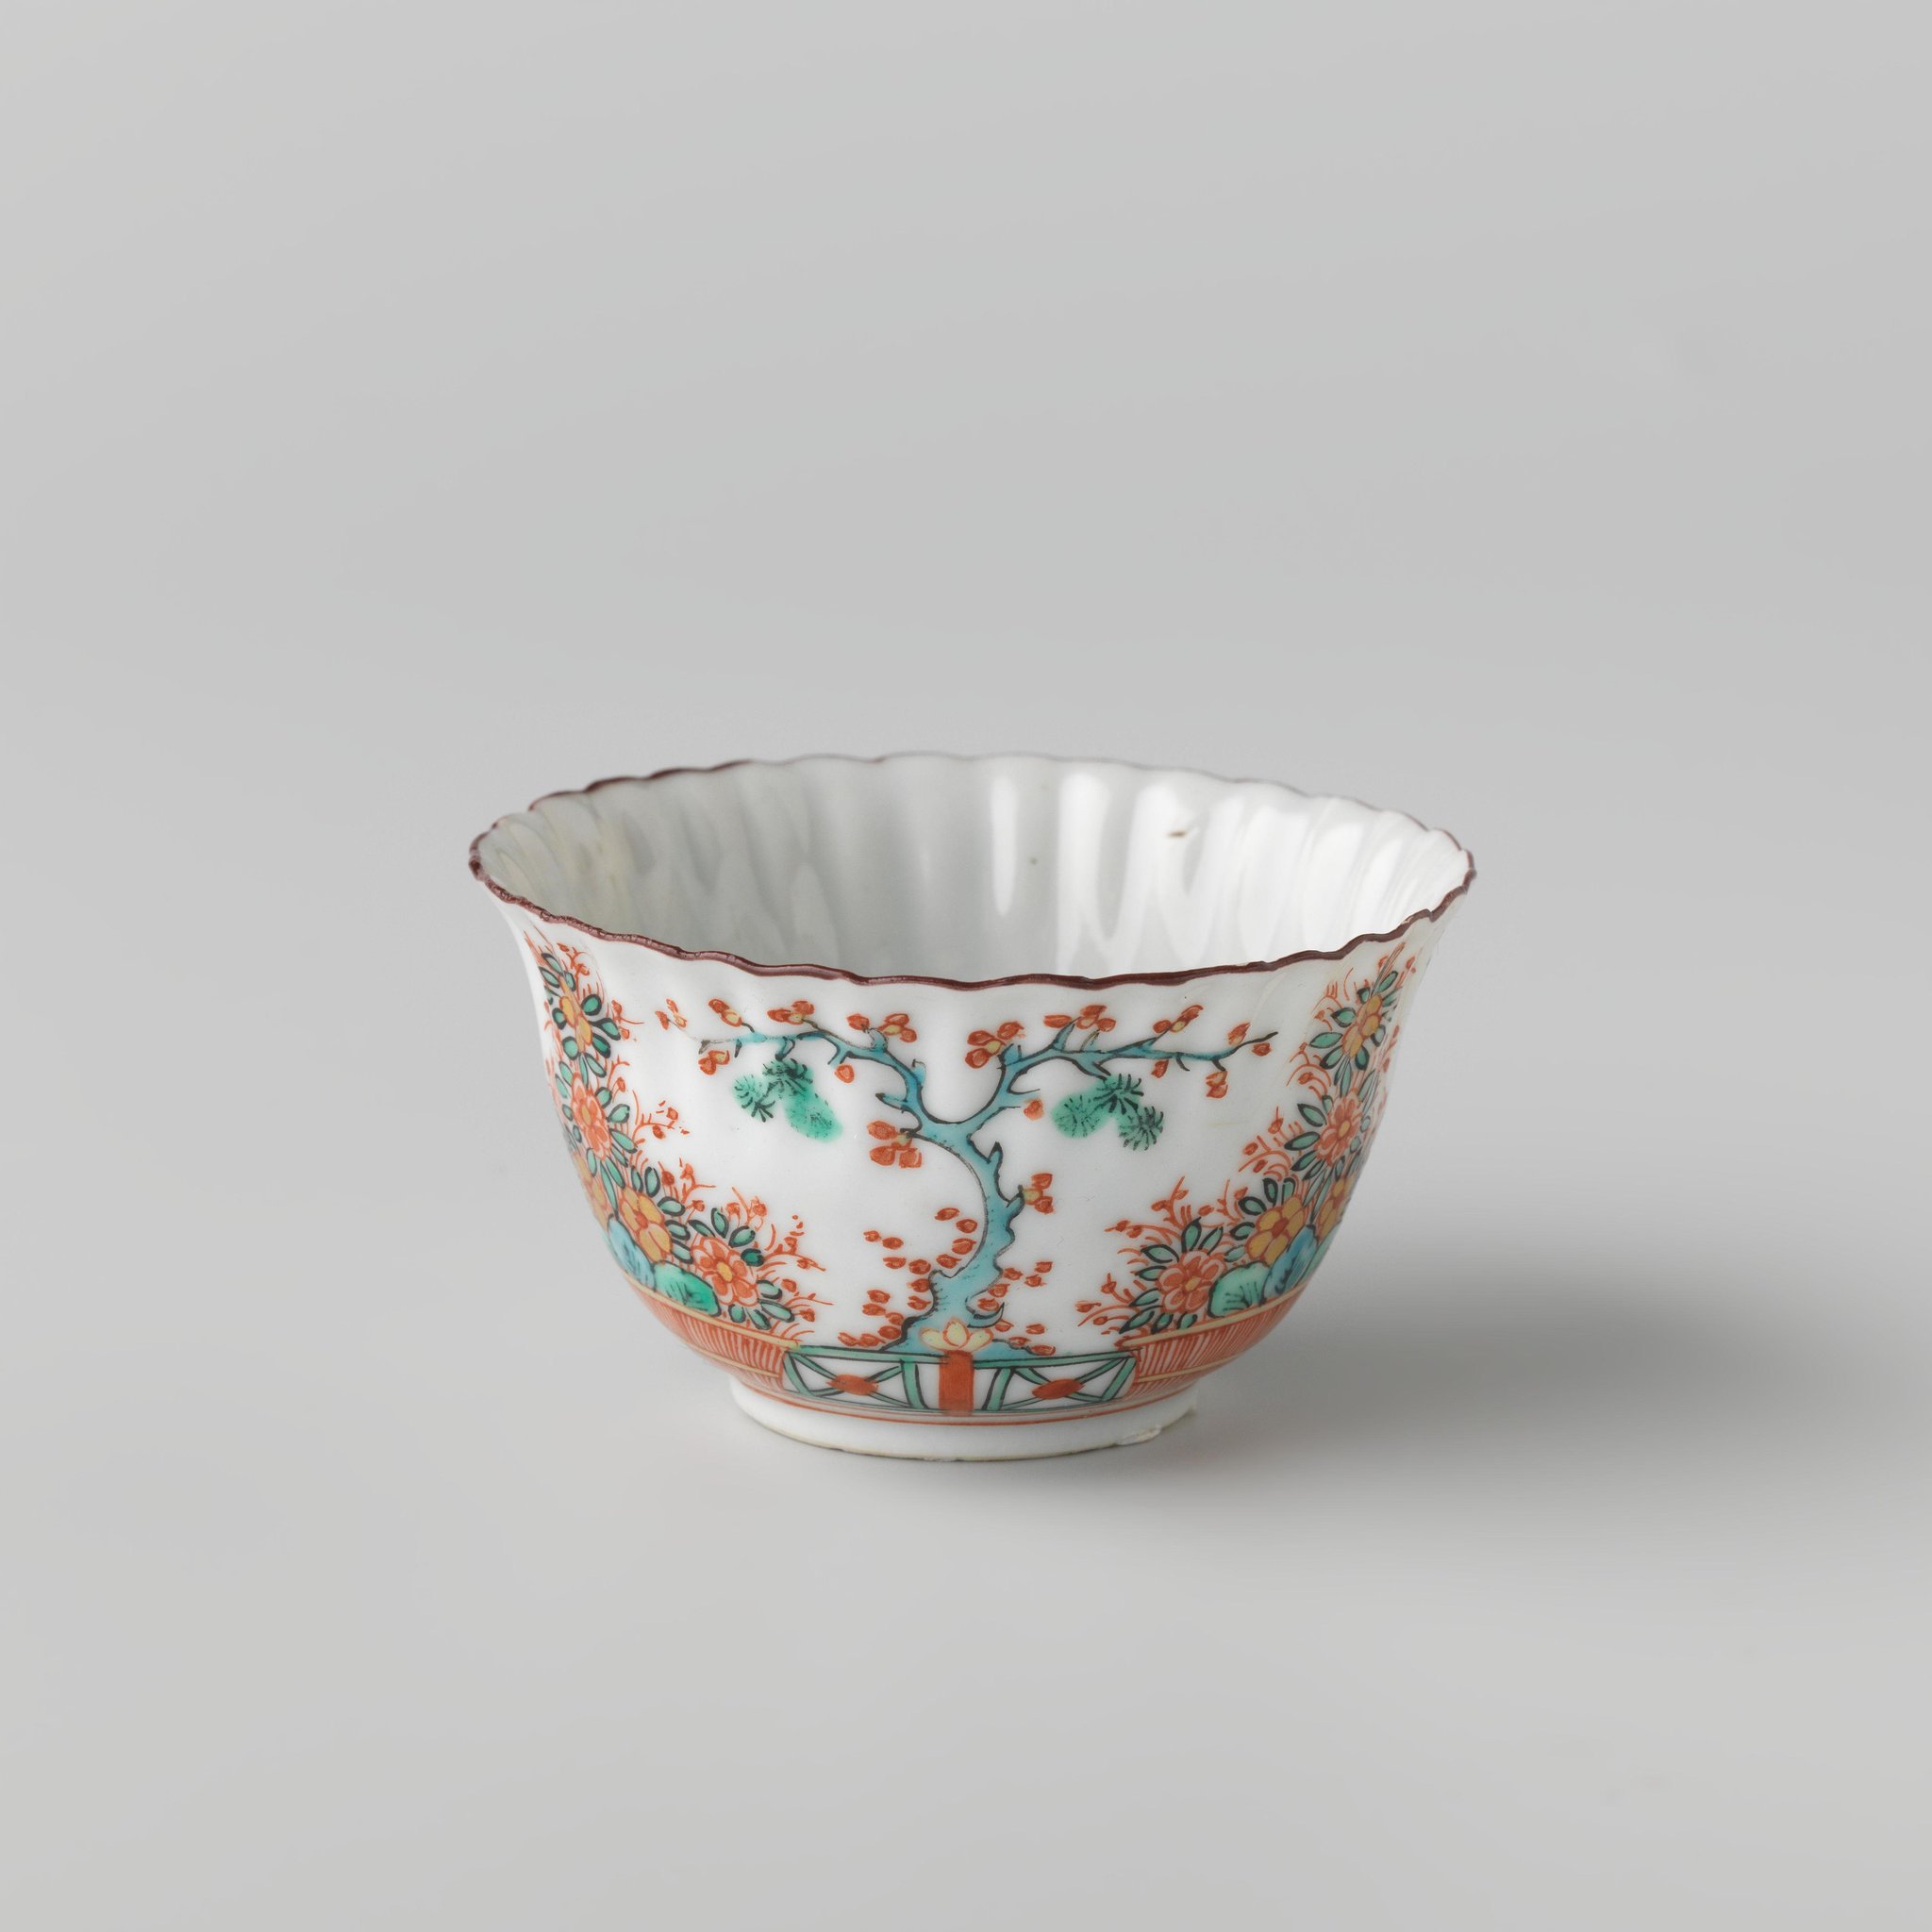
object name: cup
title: Bell-shaped cup with fluted sides with a flower basket and a tree behind a fence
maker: Anonymous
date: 1700-1749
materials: glaze, gold, paint, porcelain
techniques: firing, gilding, turning, vitrification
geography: china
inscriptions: mark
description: Klokvormige kop van porselein met een geribde wand, beschilderd op het glazuur in blauw, rood, groen, zwart en goud. Op de wand een bloemrozet; daaromheen een medaillon waarop afwisselend drie bloemenmanden en driemaal een boom achter een hek. Gemerkt op de onderzijde met een imitatiemerk. In Europa gedecoreerd.